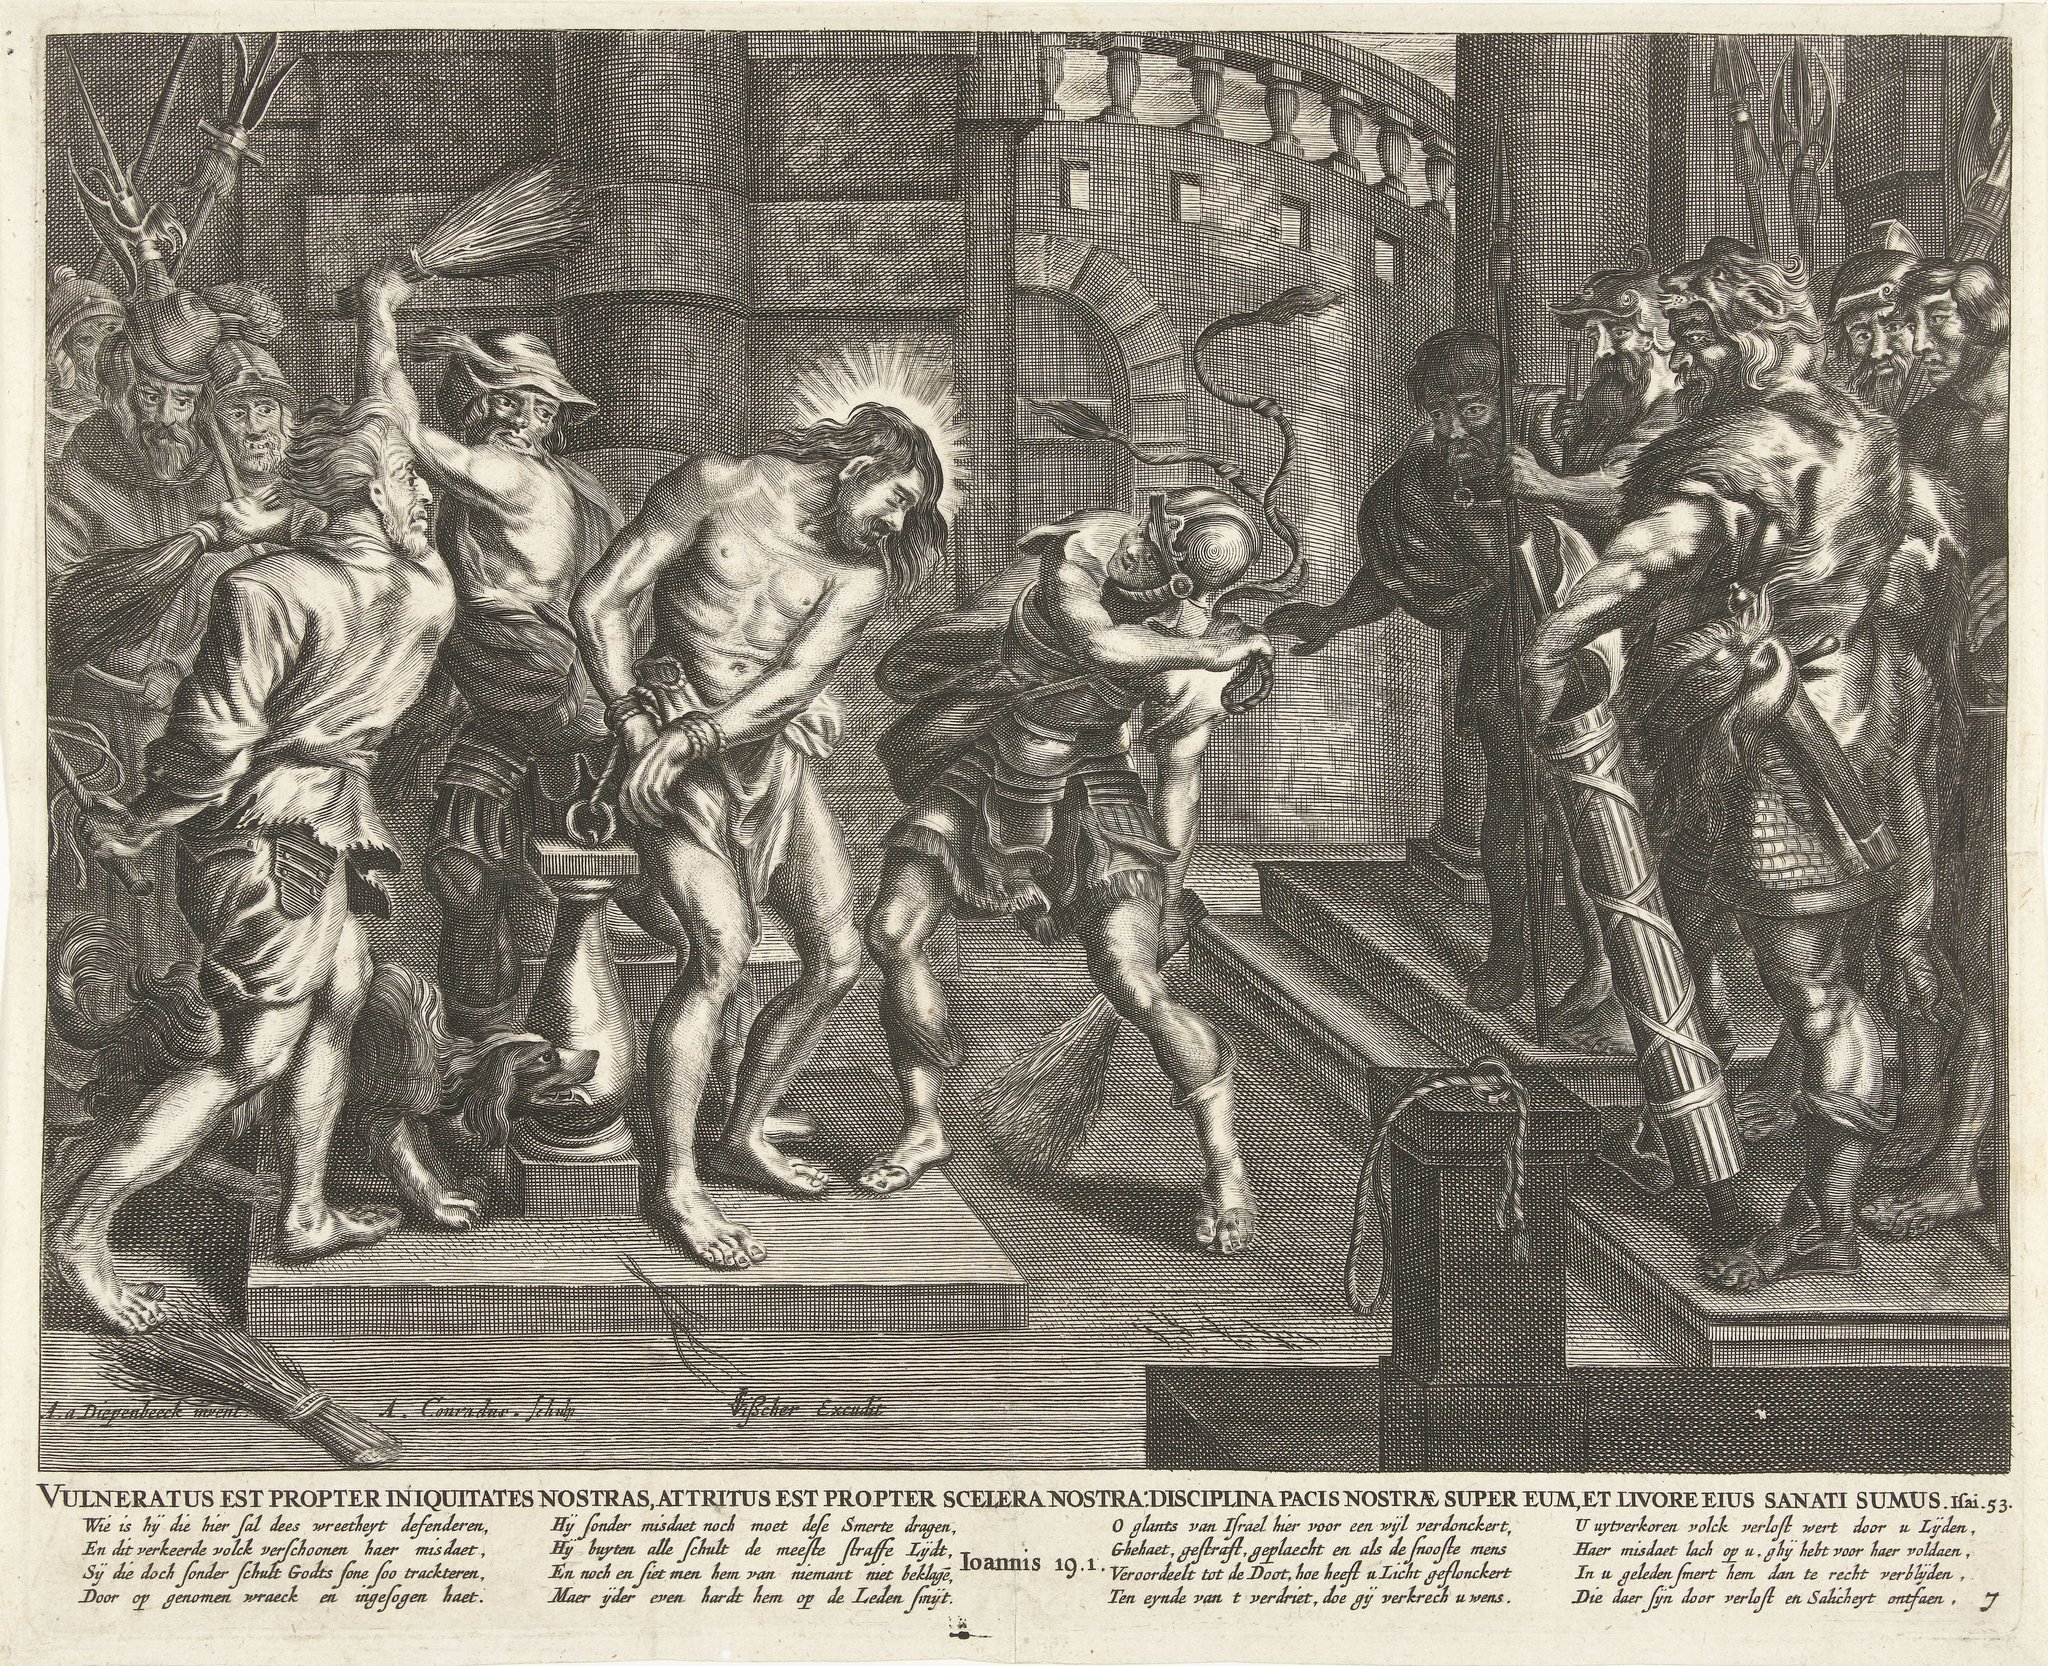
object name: print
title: Geseling van Christus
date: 1627-1661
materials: paper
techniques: engraving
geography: amsterdam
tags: flagellation by soldiers, christ usually tied to a column (matthew 27:26; mark 15:15; john 19:1)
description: Christus is vast gebonden aan een halfhoge zuil in het huis van Pilatus. Hij wordt door drie soldaten geslagen met geselriemen en roedes. Linksachter en rechts staan groepen soldaten naar de marteling te kijken. Onder de voorstelling het bijbelvers Joh. 19:1 in het Latijn en Nederlands.